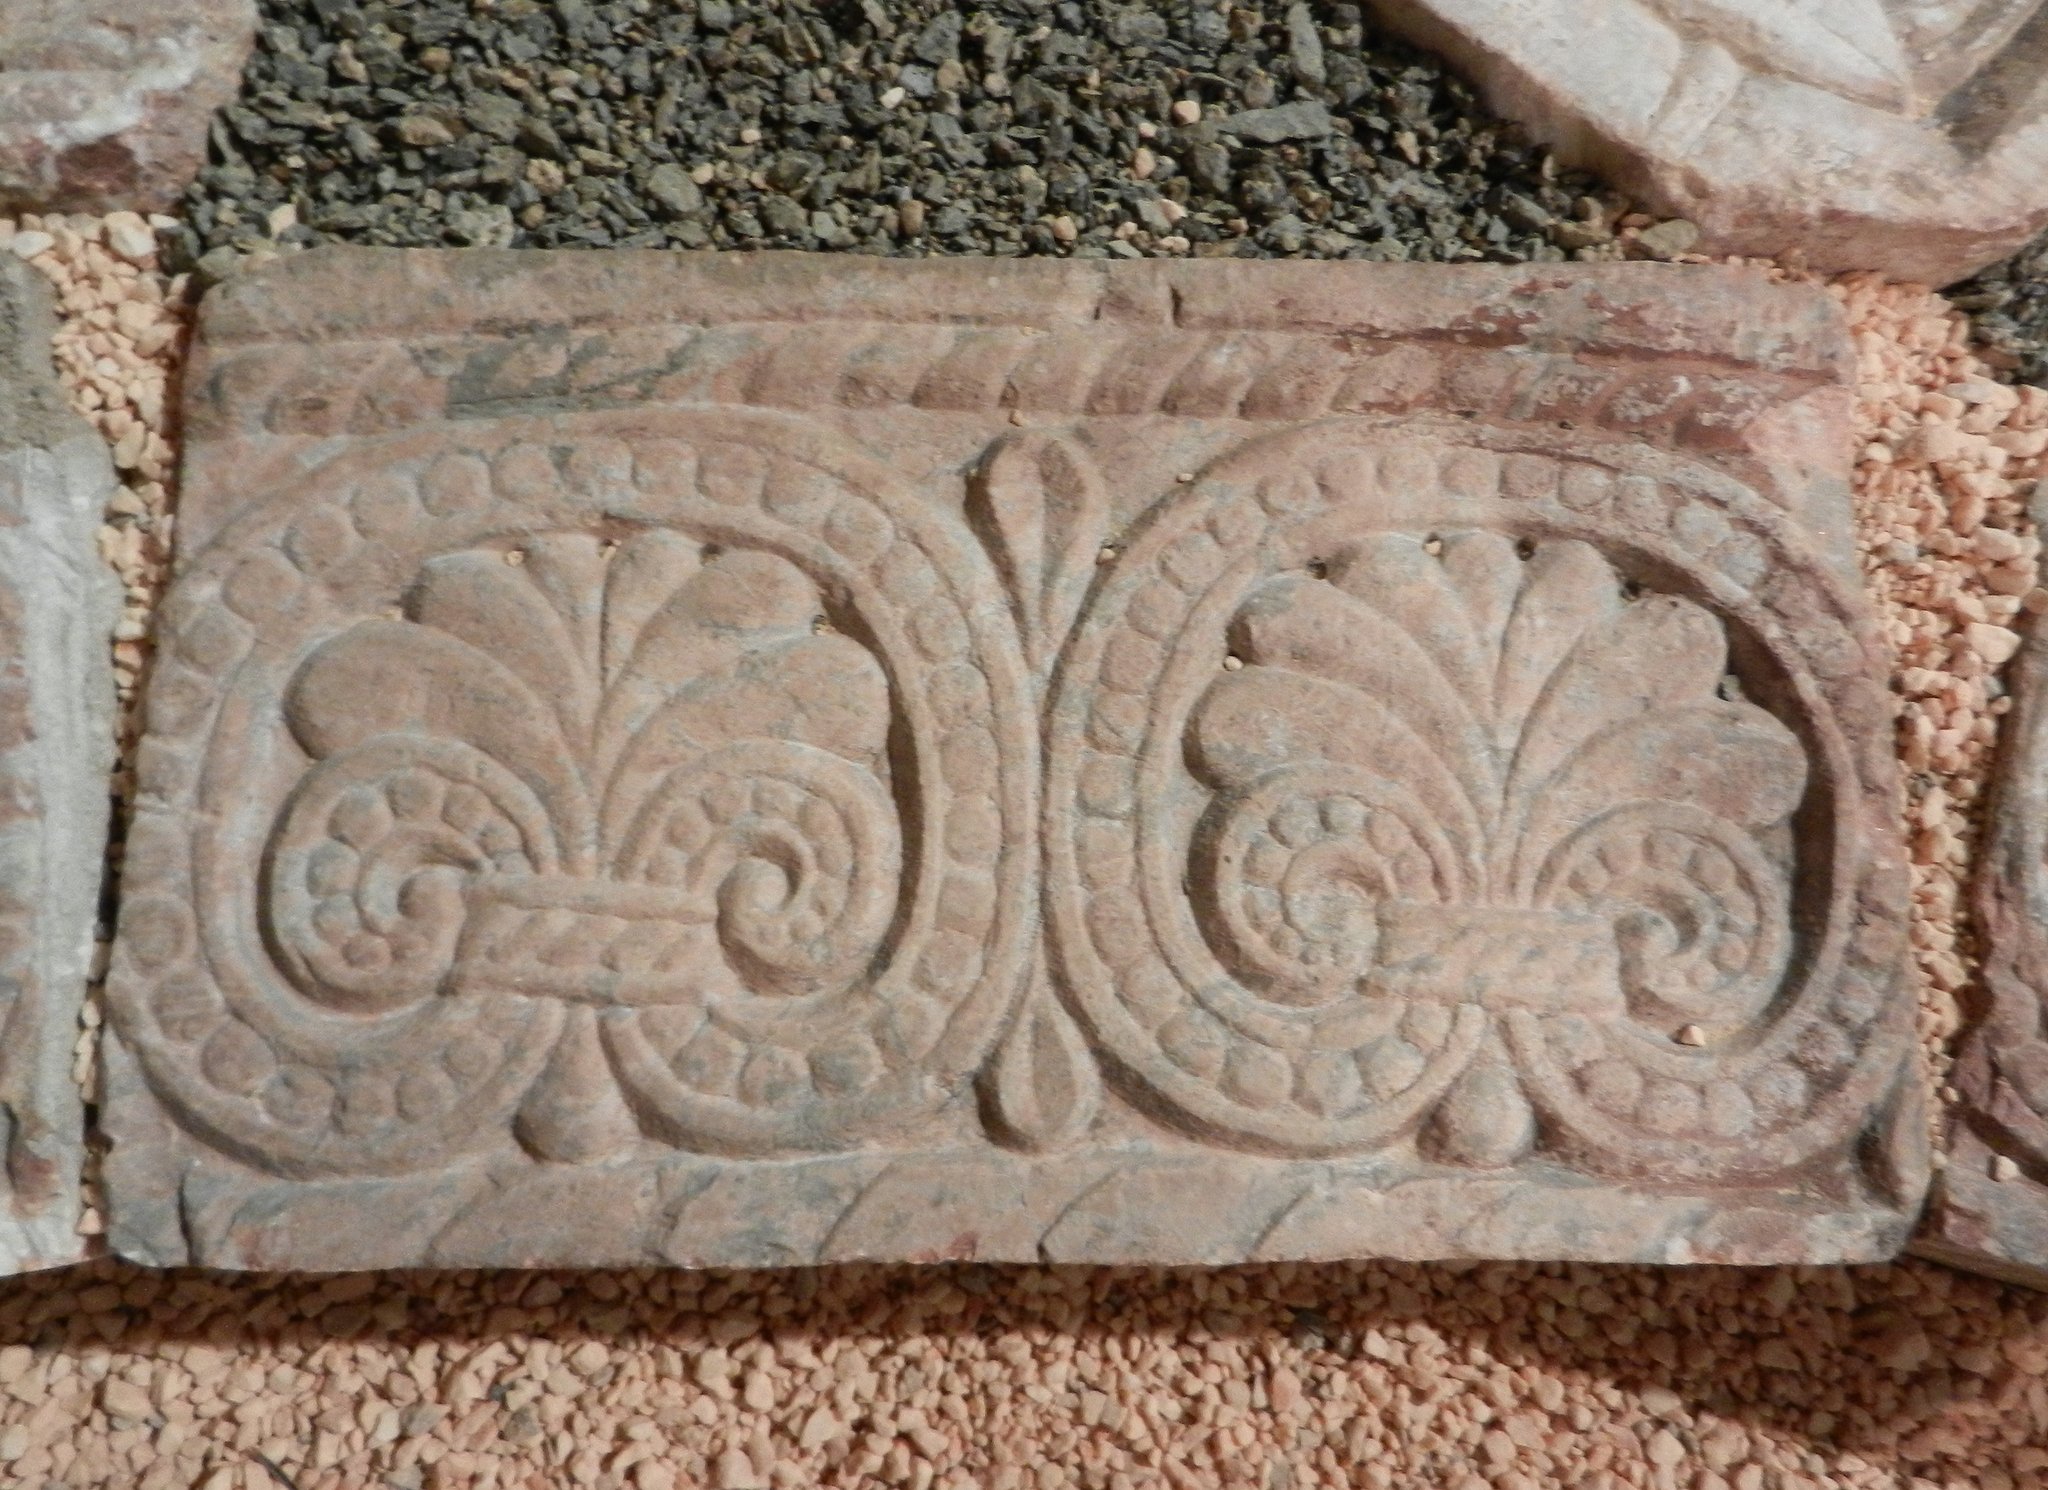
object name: fragment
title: Lintel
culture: catalan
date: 1130-1140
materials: marble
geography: france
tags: palmettes